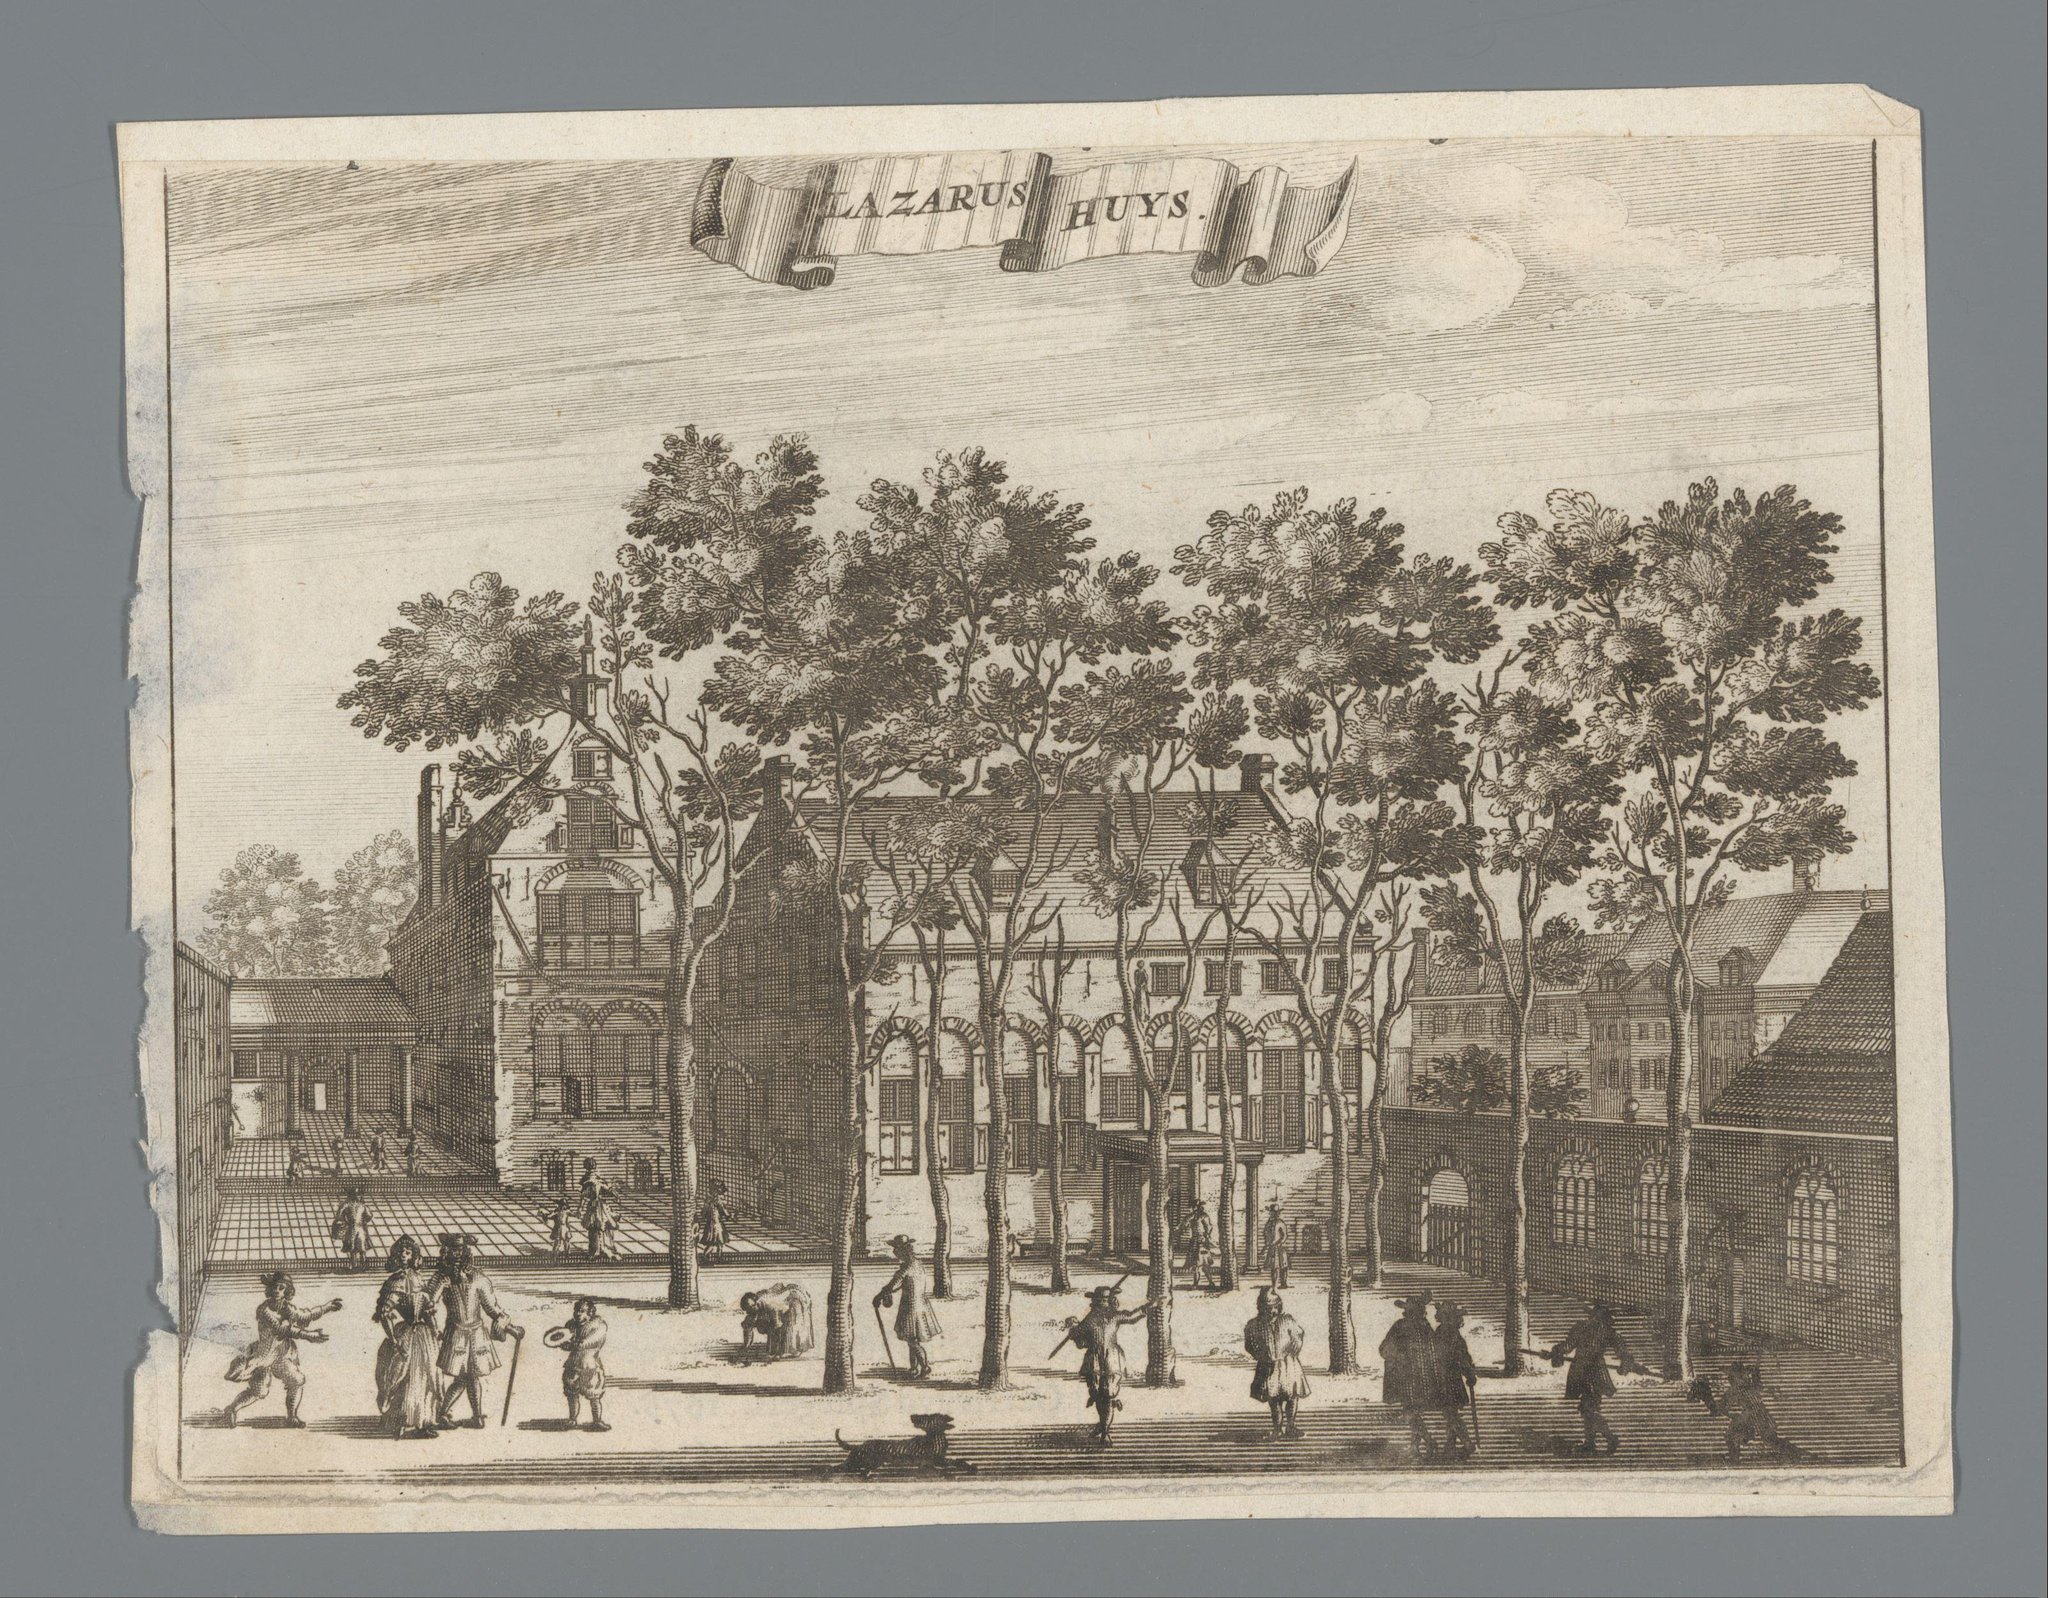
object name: book illustration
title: Gezicht op de binnenplaats van het Leprozenhuis te Amsterdam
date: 1693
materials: paper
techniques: etching, letterpress printing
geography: amsterdam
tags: leprosarium, public welfare, hospital, lunatic asylum, mental home, street (+ city(-scape) with figures, staffage)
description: Prent uit: Commelin, Caspar. Beschryvinge van Amsterdam, desselfs eerste oorspronk uyt den Huyse (…). Amsterdam: Abraham Wolfgang et al., 1693, p. 552. Later in heruitgaven in 1694 en 1726 verschenen.